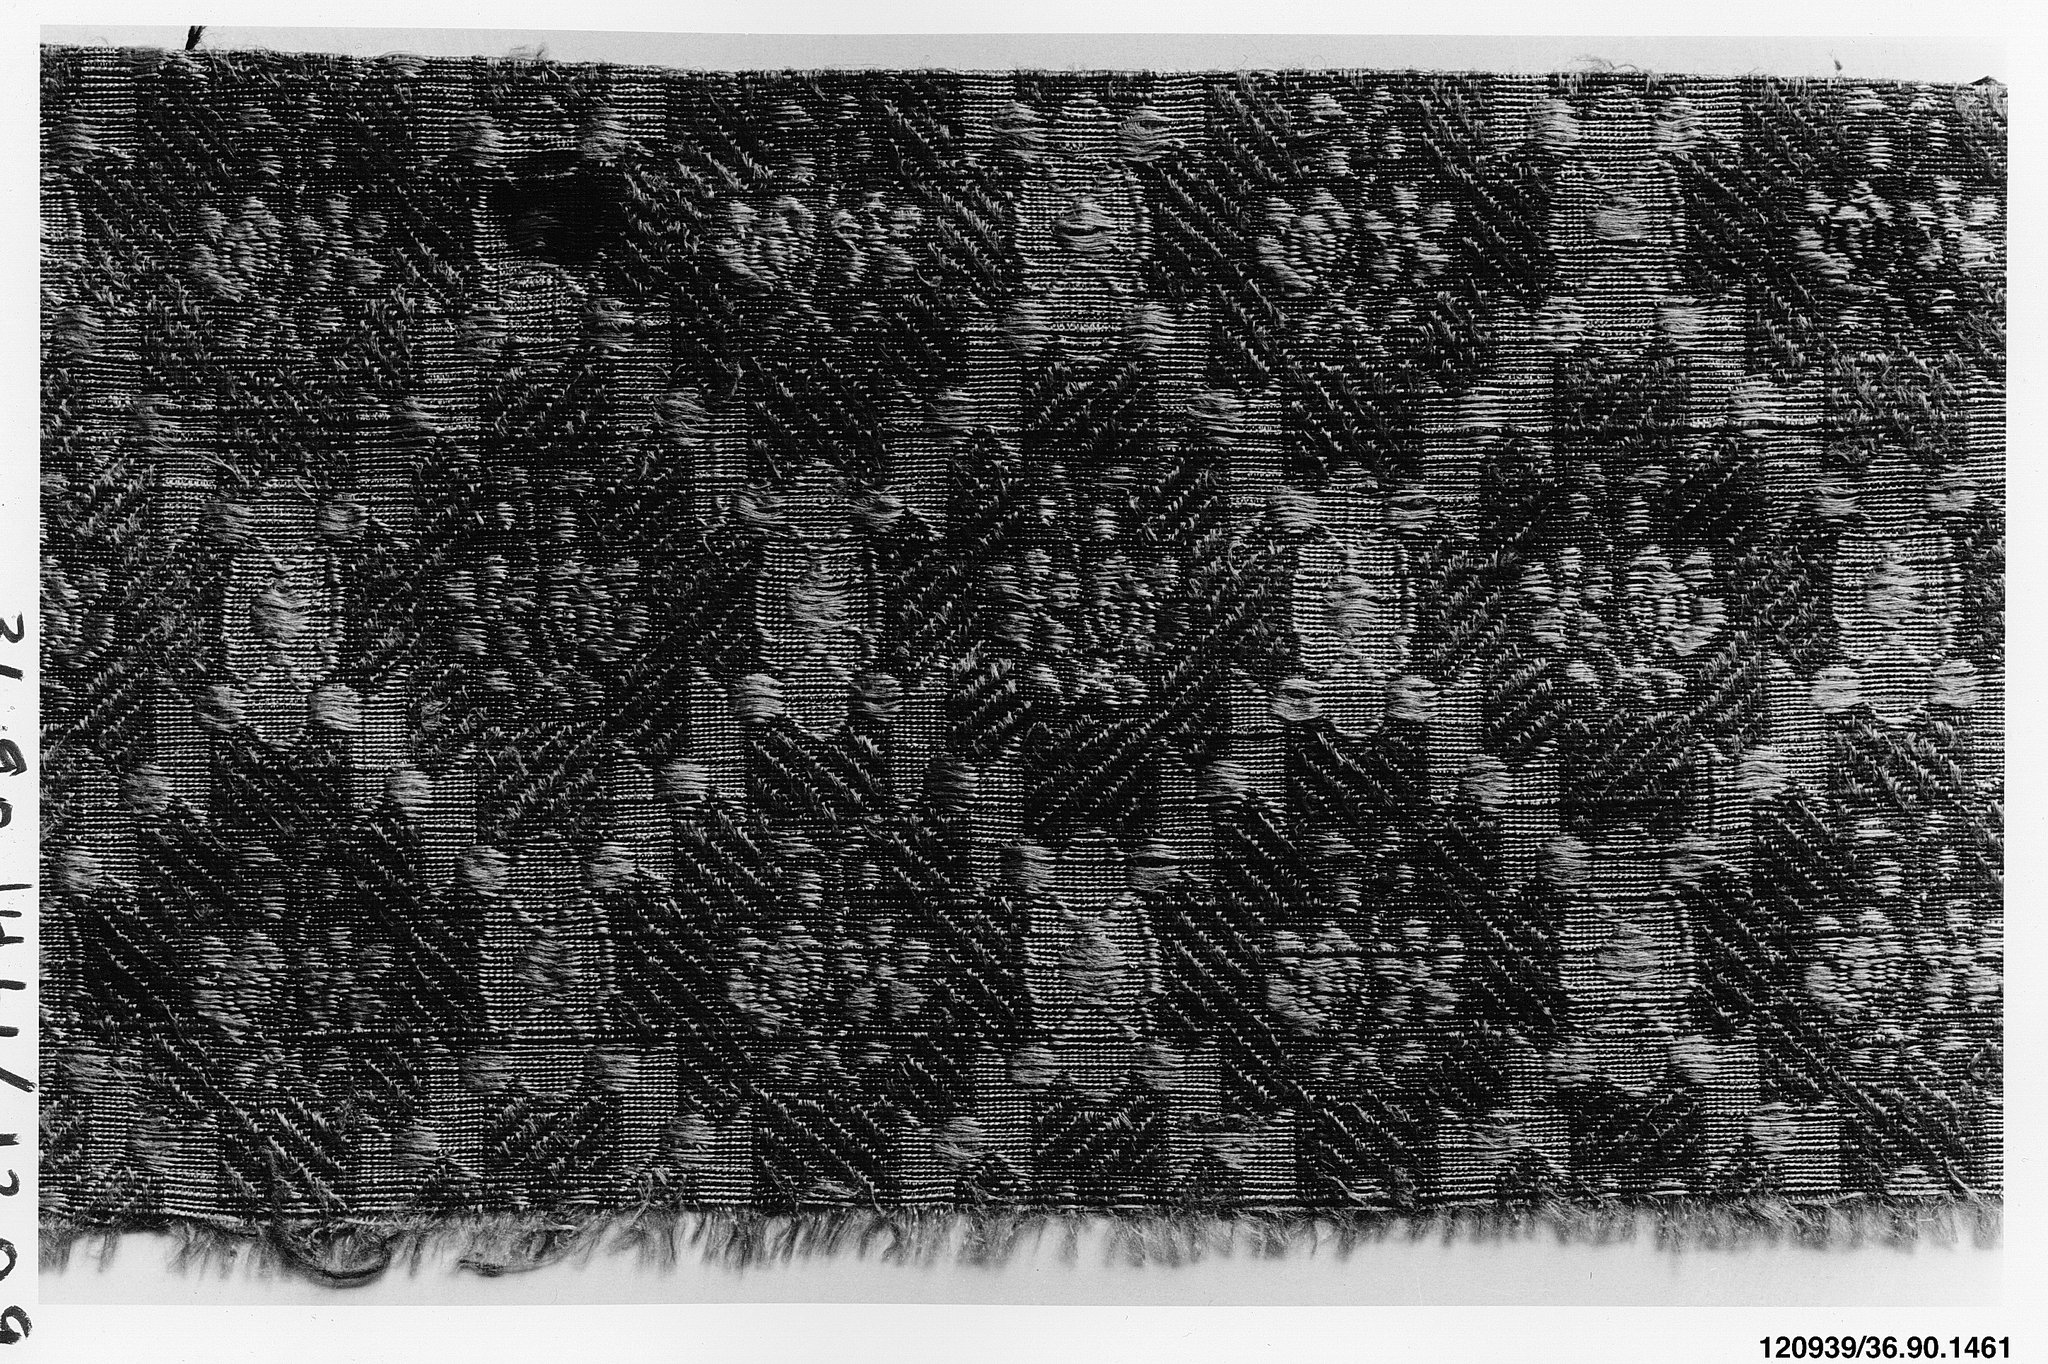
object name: piece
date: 1701-1800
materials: silk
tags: flowers